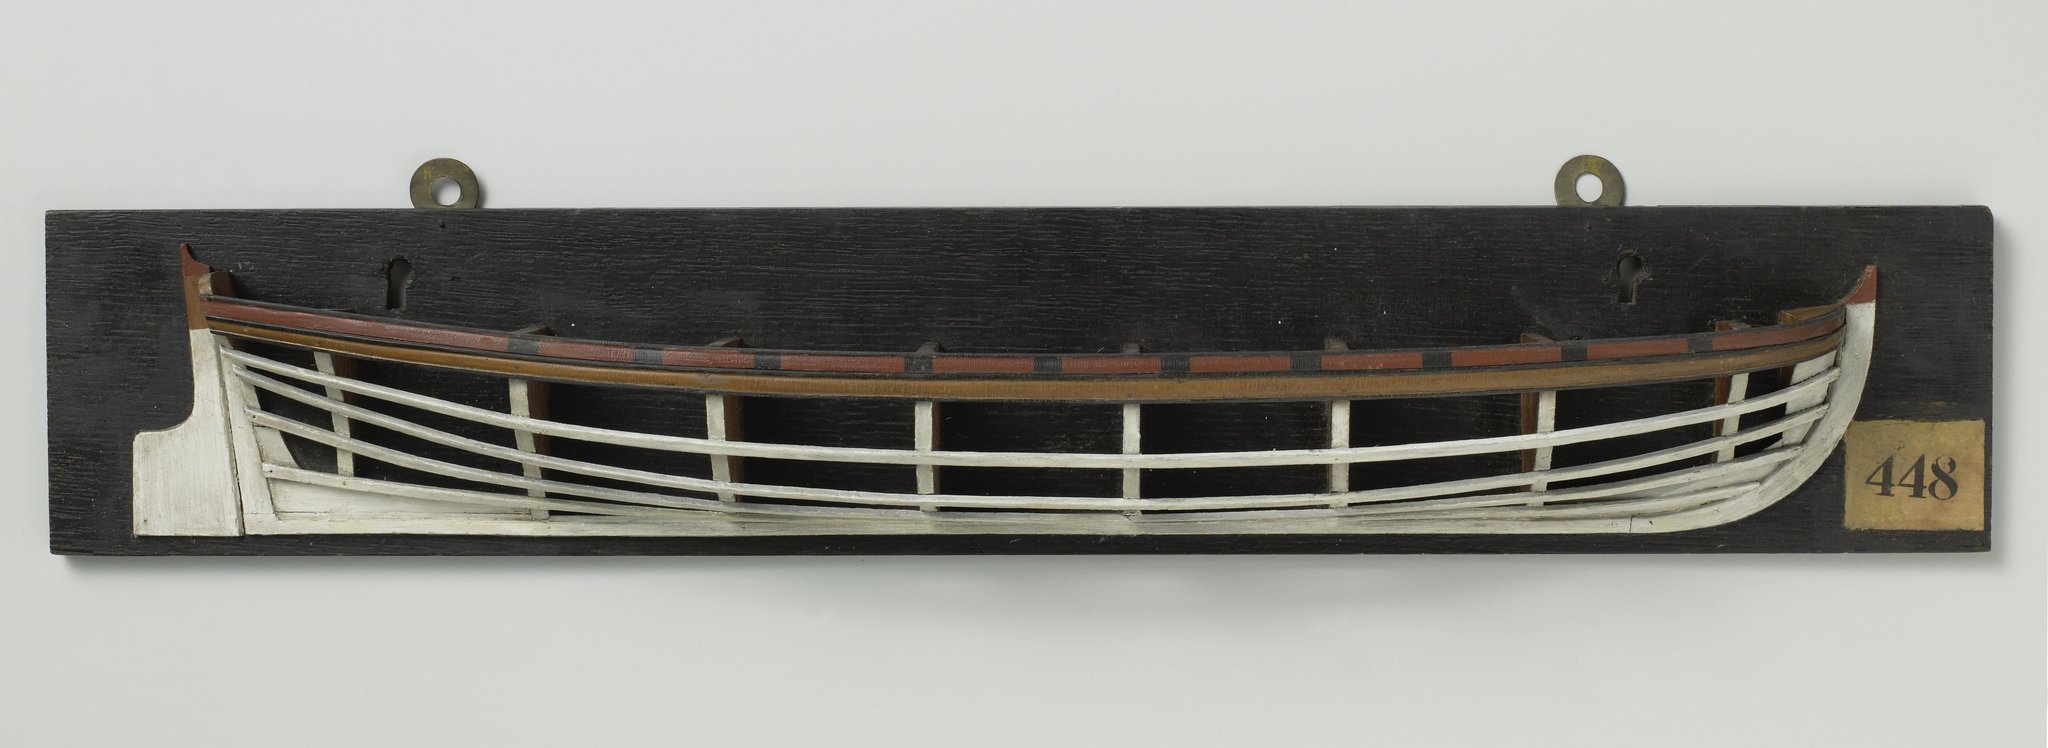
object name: builder's model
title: Half Model of a Launch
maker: Anonymous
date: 1780-1820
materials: wood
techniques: polychromy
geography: netherlands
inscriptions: label, bottom right: ‘448’ former inventory label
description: Gepolychromeerd mallenmodel (stuurboord) van een roeiboot. Het boeisel boven het barkhout is gesloten. Tien scheegaten zijn aangegeven. Platte spiegel, breed roer. De zeeg loopt op naar beide uiteinden, één barkhout. Gepiekt rondspant.